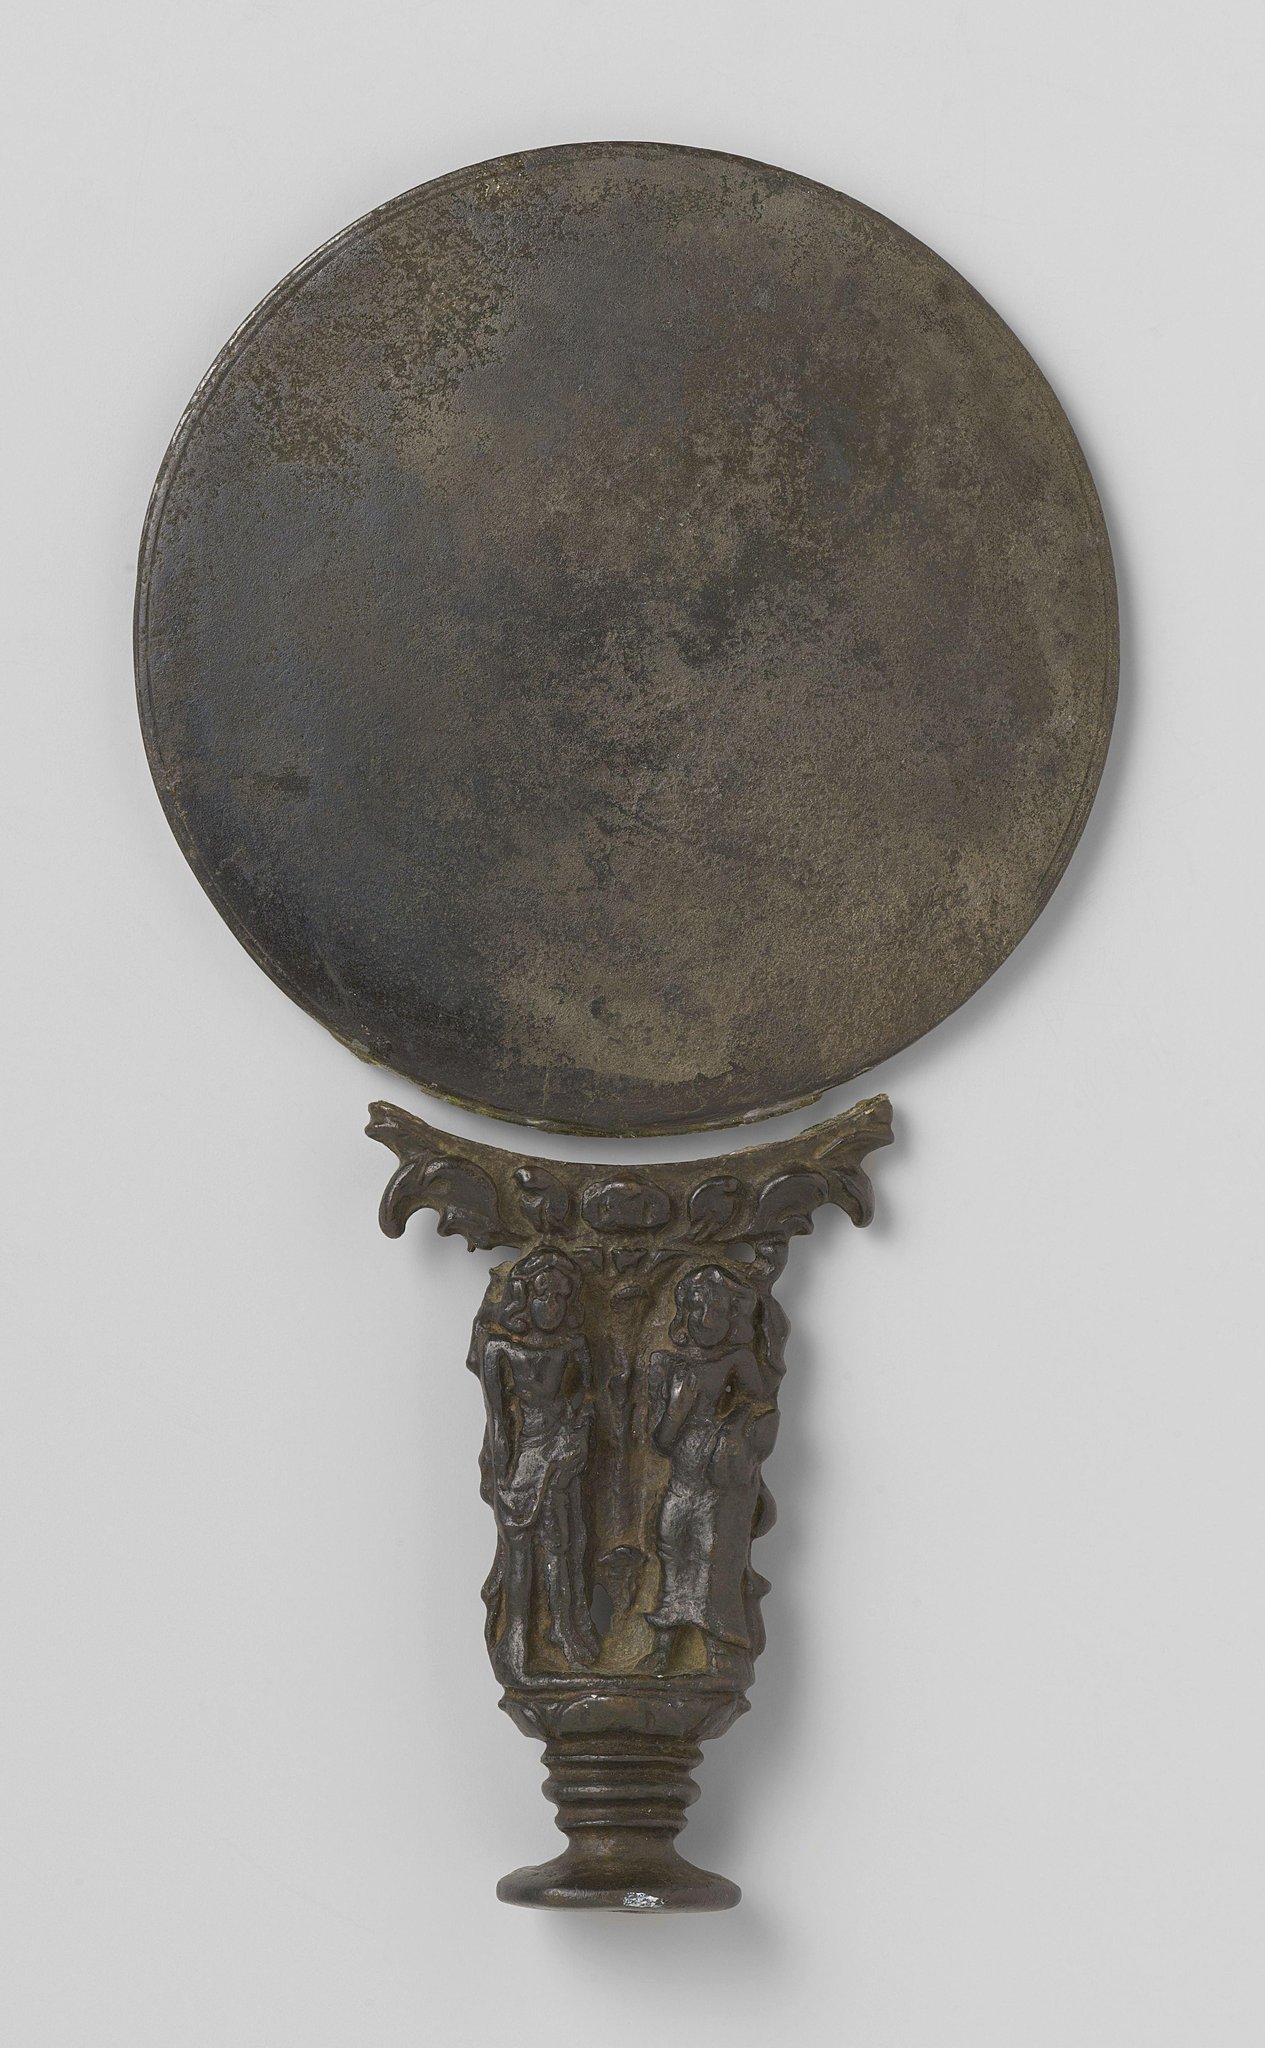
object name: mirror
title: Spiegel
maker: Anonymous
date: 1200-1500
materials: bronze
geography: indonesia